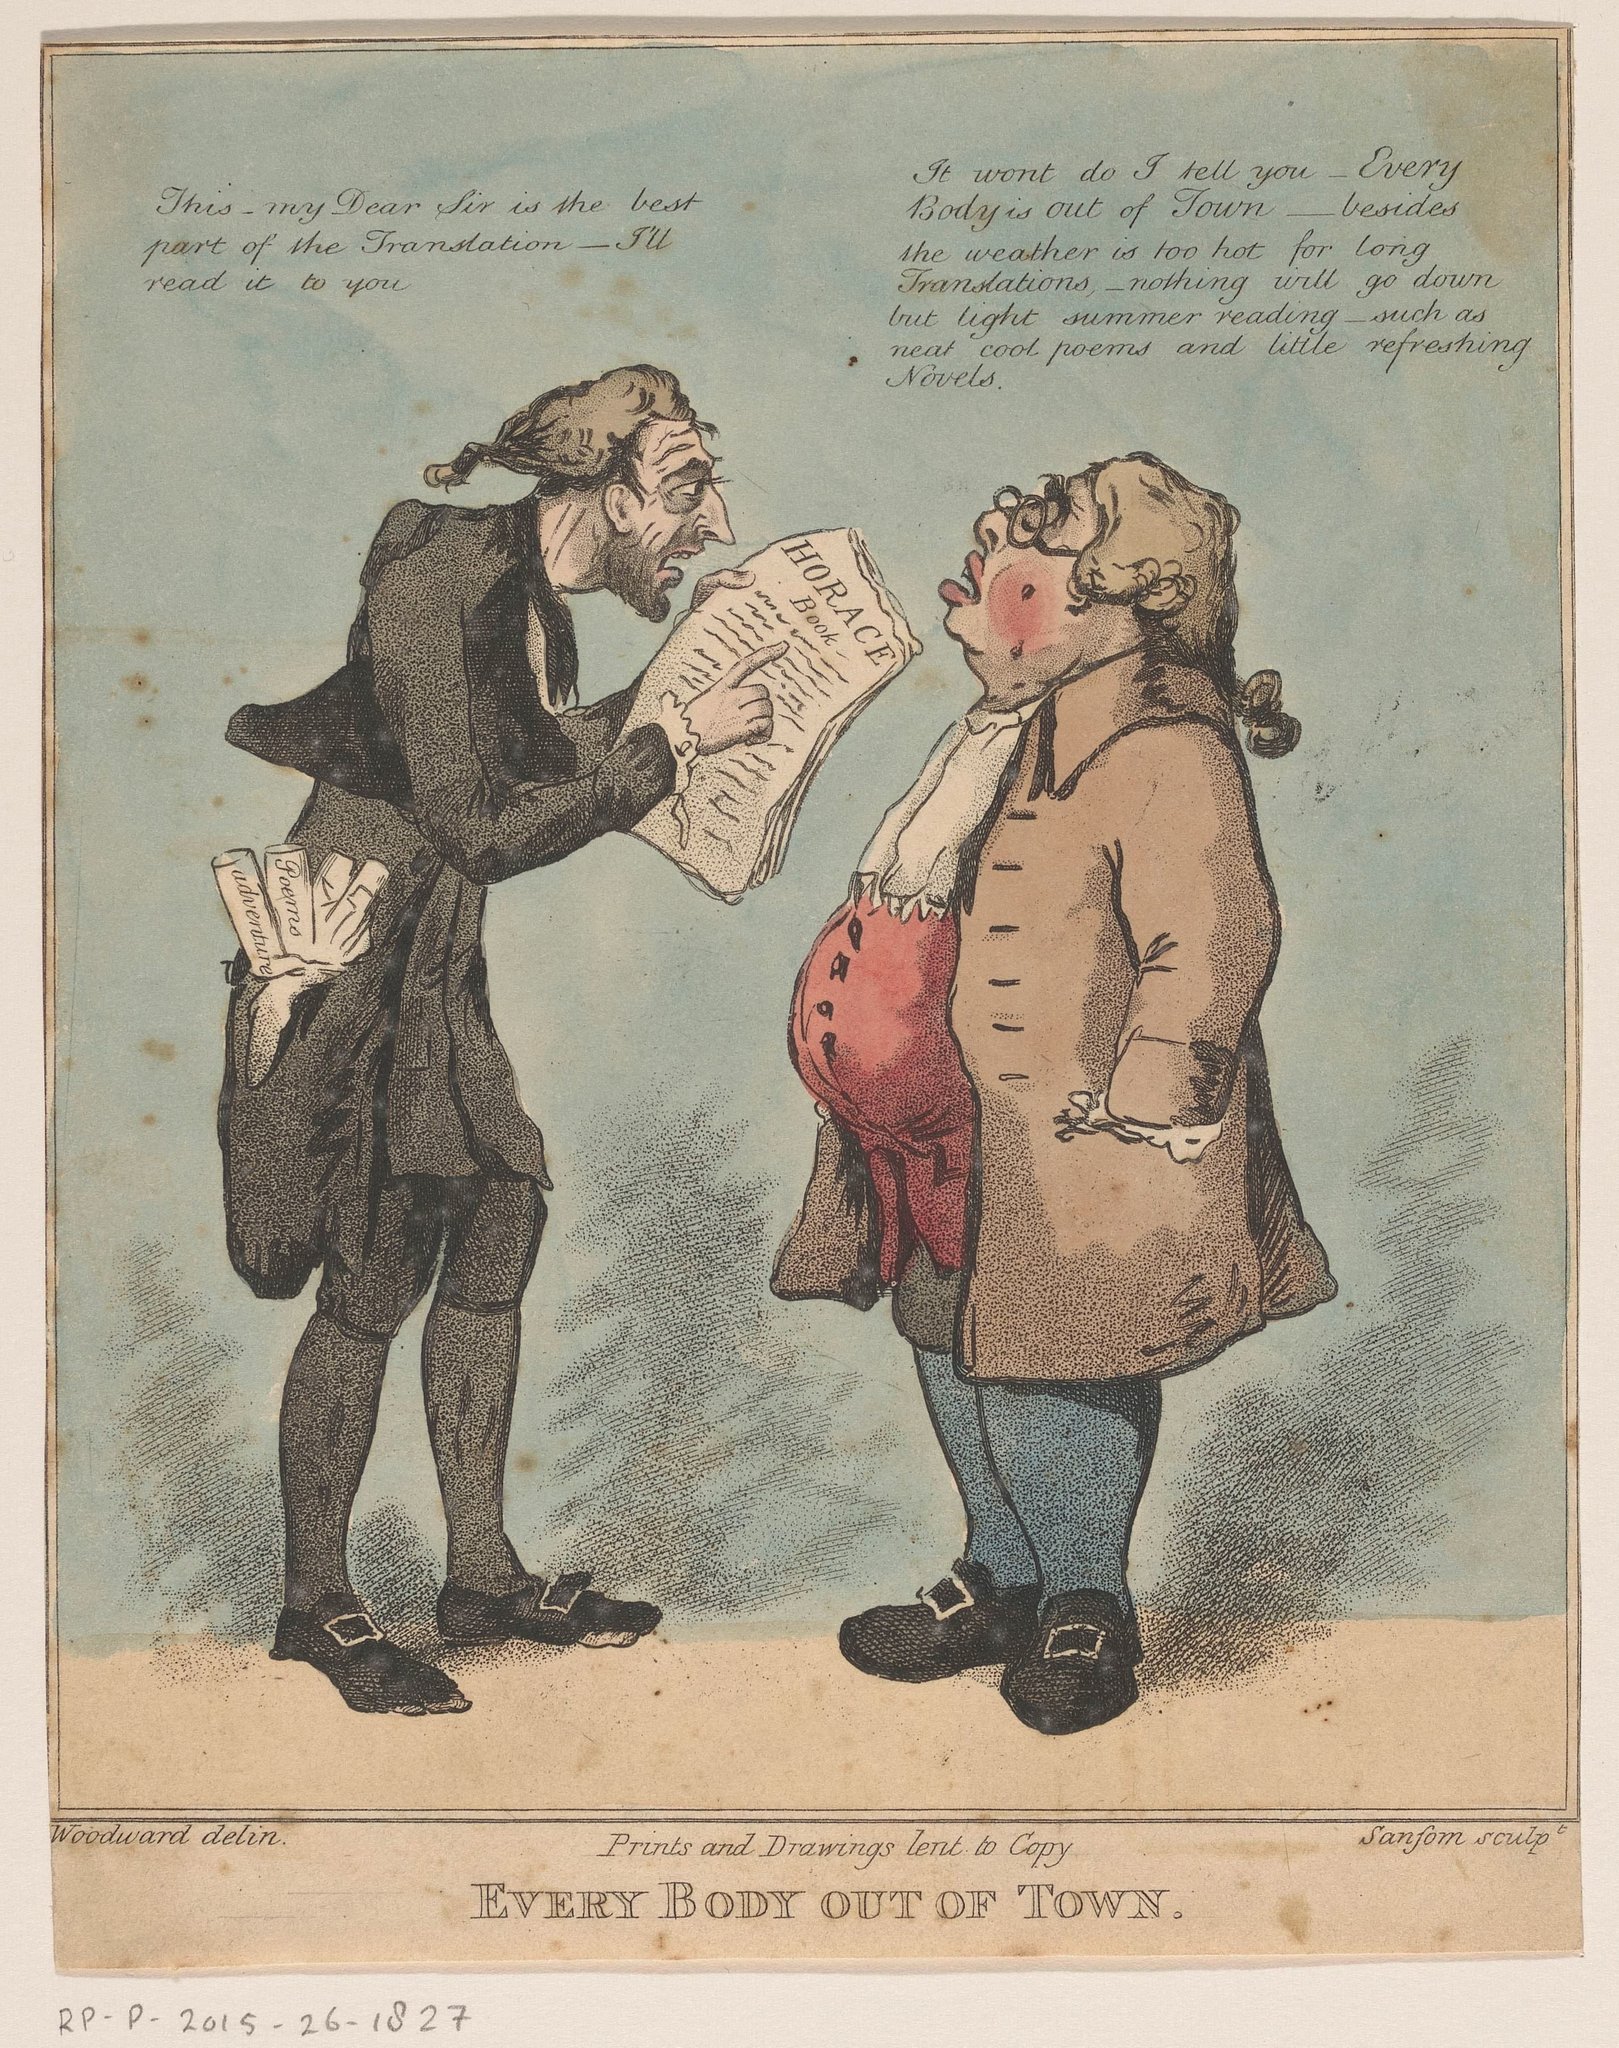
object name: print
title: Schrijver en een uitgever bespreken vertaling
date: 1800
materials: paper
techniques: etching, hand coloring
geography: london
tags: publishing, publisher, writer, poet, author, newspaper, news-sheet, political caricatures and satires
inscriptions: collector's mark: Lugt 4779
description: Een armoedig geklede schrijver met een krant in zijn handen staat tegenover een dikke, goed geklede uitgever. De schrijver probeert de uitgever te enthousiasmeren voor een vertaling van Horatius. Deze antwoordt dat niemand interesse heeft in ingewikkelde teksten in de zomer.